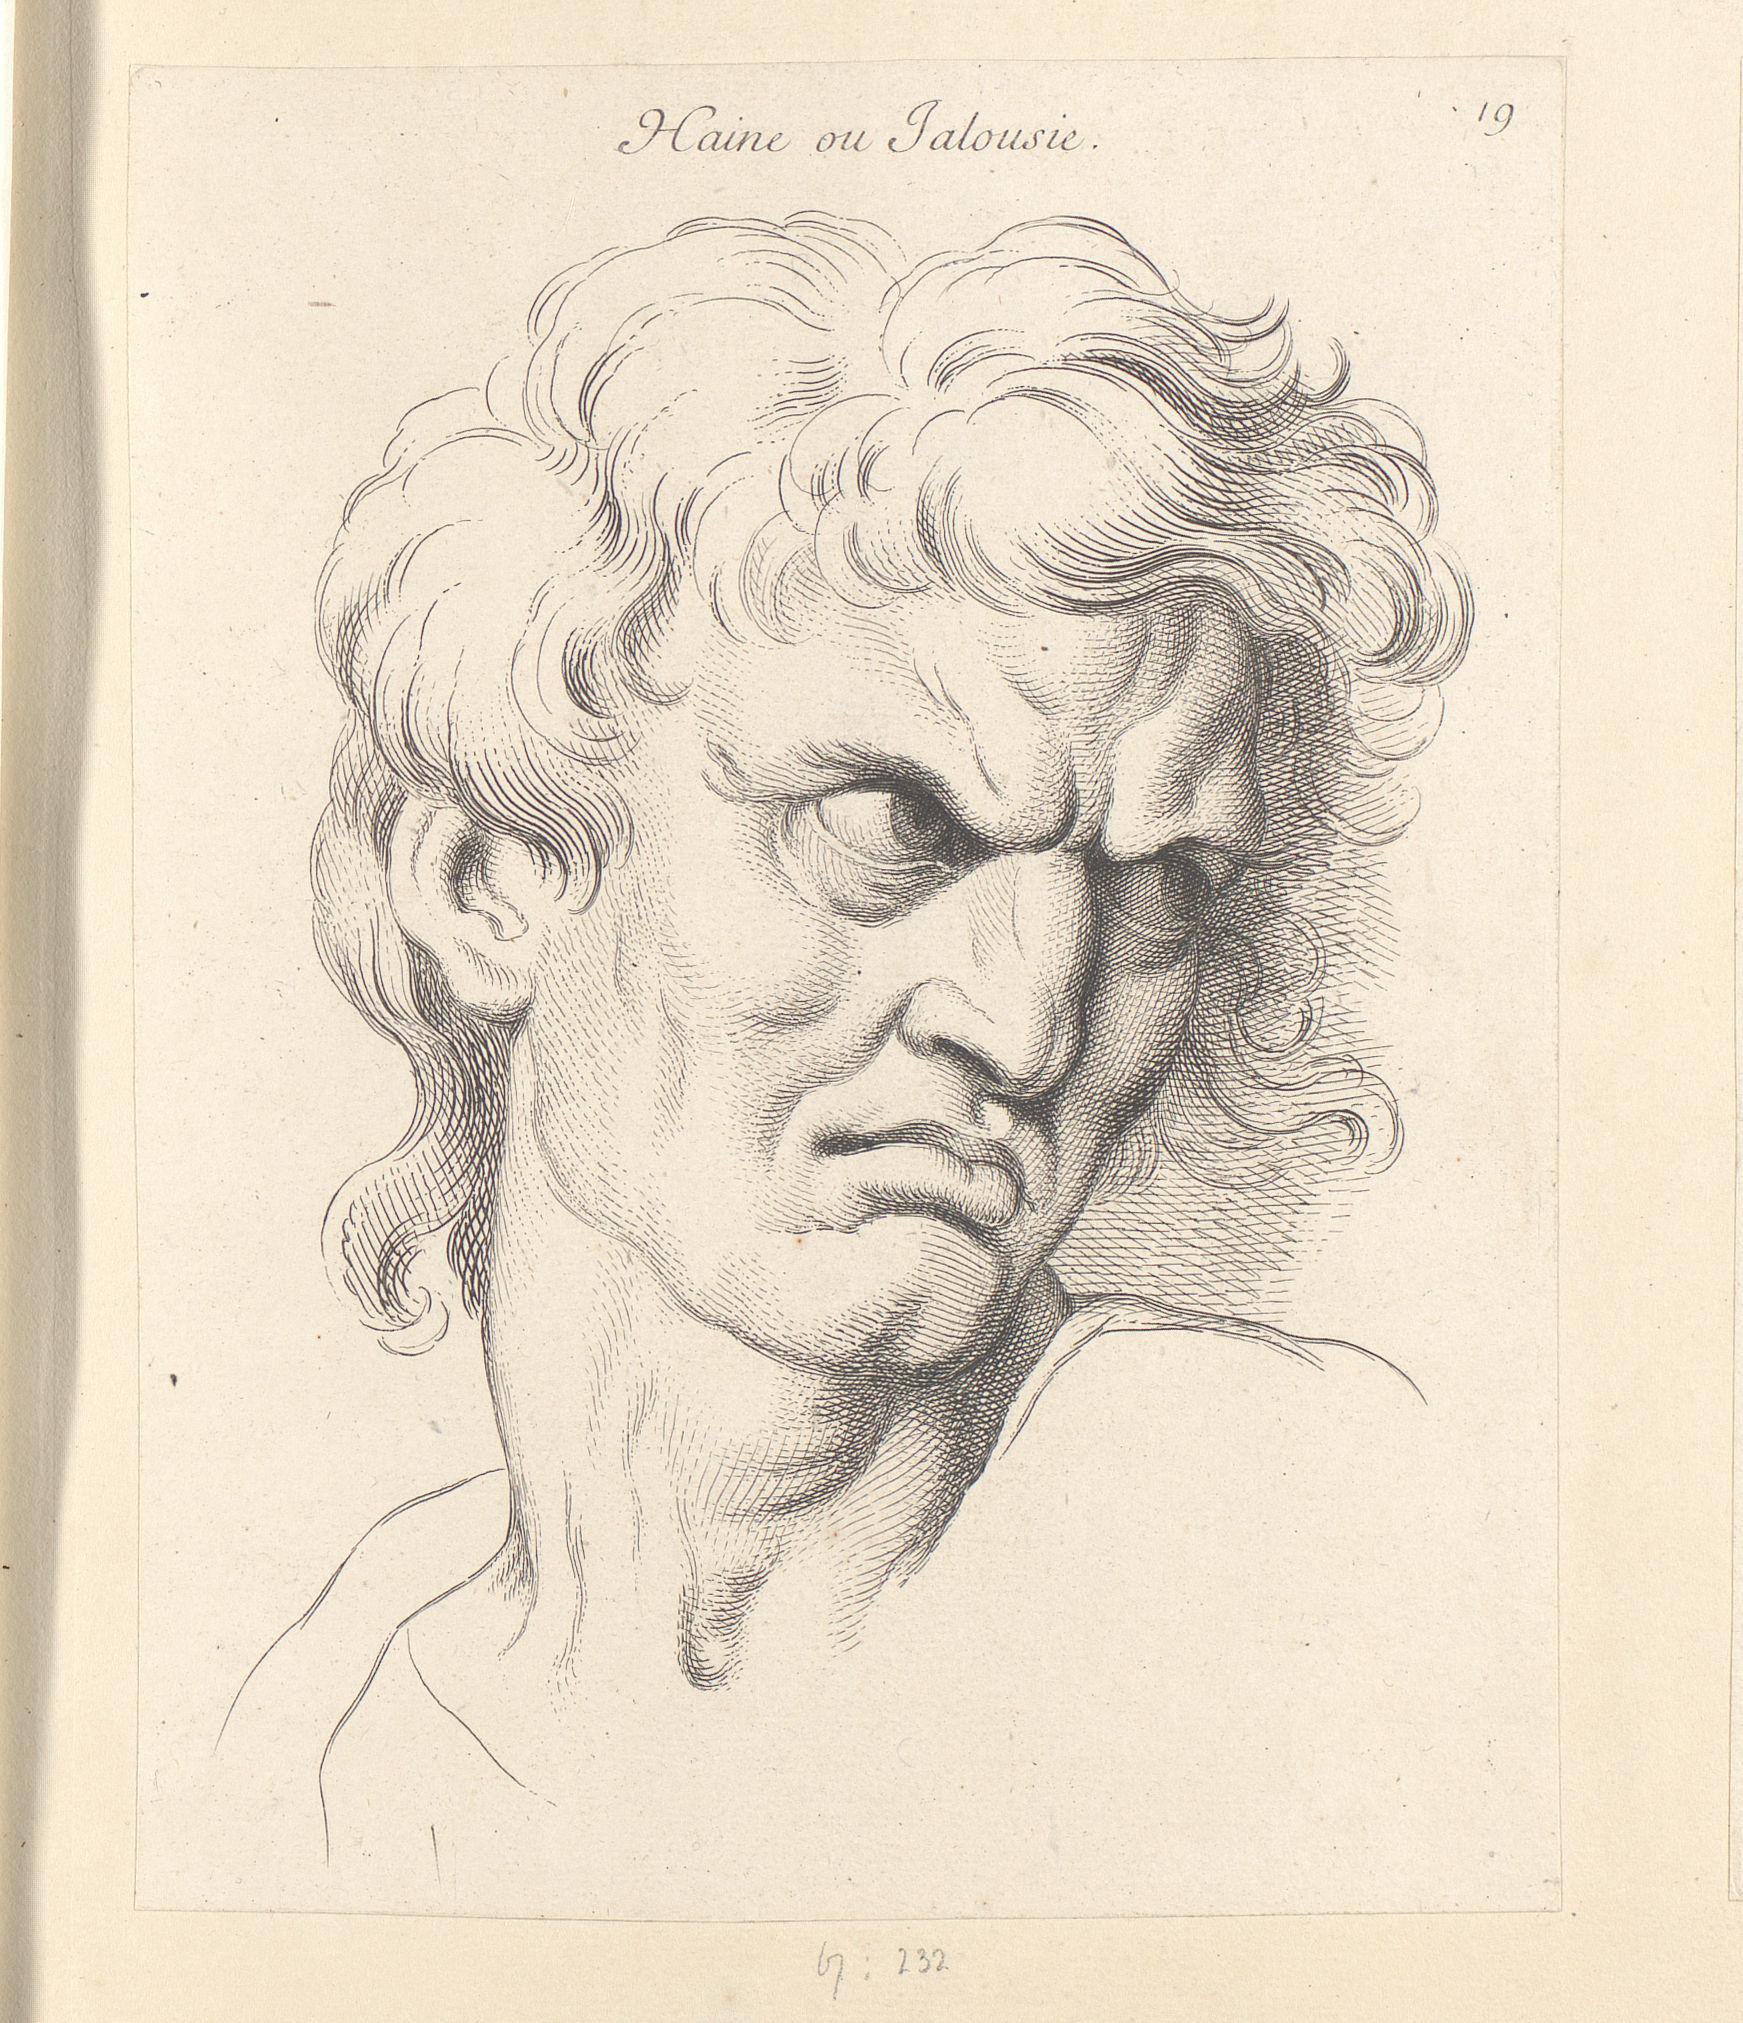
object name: album leaf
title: Expressions des Passions de l'Ame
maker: jean audran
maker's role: print maker, publisher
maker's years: 1667-1756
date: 1727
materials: paper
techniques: engraving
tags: face, morphology of facial expression, jealousy; 'gelosia', 'rammarico del ben'altrui' (ripa)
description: Prent uit: Le Brun, Charles. Expressions des Passions de l'Ame. Representées en plusieurs testes gravées d'apres les desseins de feu Monsieur le Brun, Premier Peintre du Roy. Parijs: Jean Audran, 1727. Reeks van 19 portretten, een titelprent en twee (dubbelzijdig bedrukte) bladen tekst.